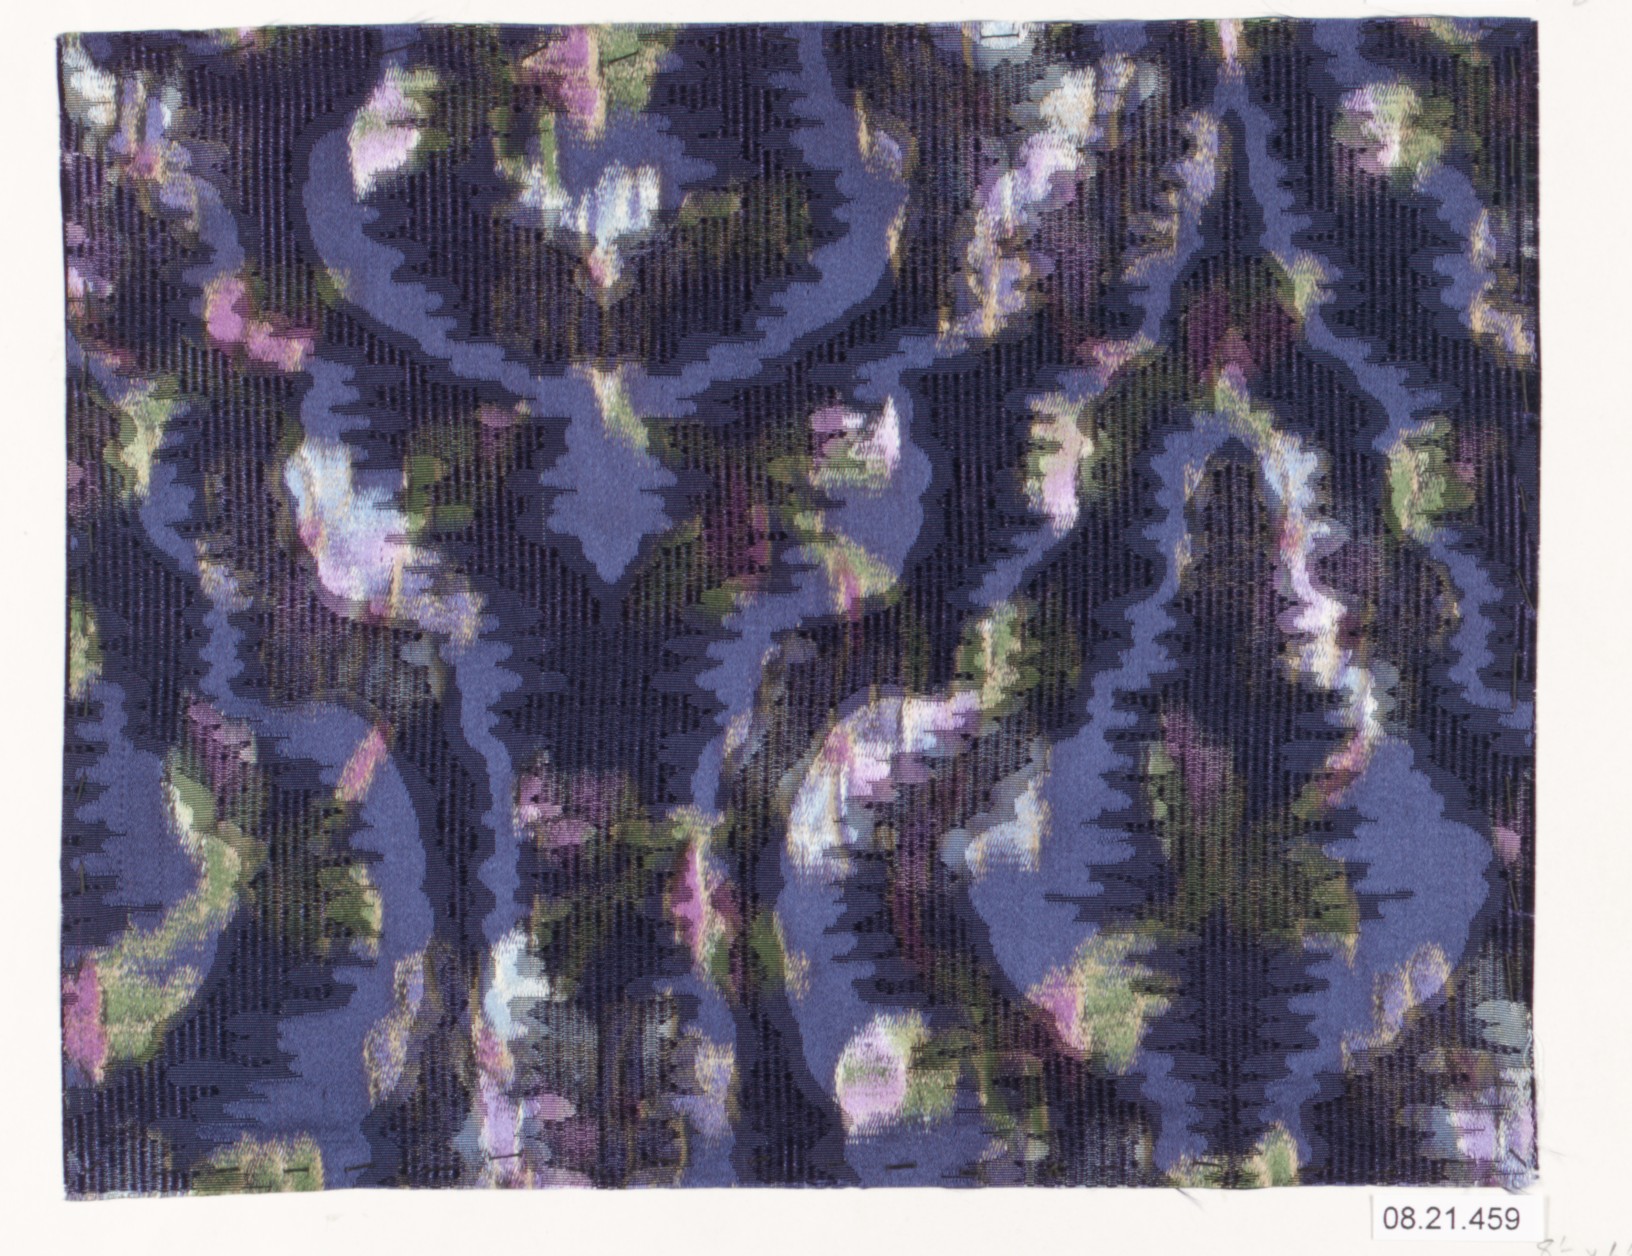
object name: textile sample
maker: Anonymous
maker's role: designer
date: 1900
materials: silk